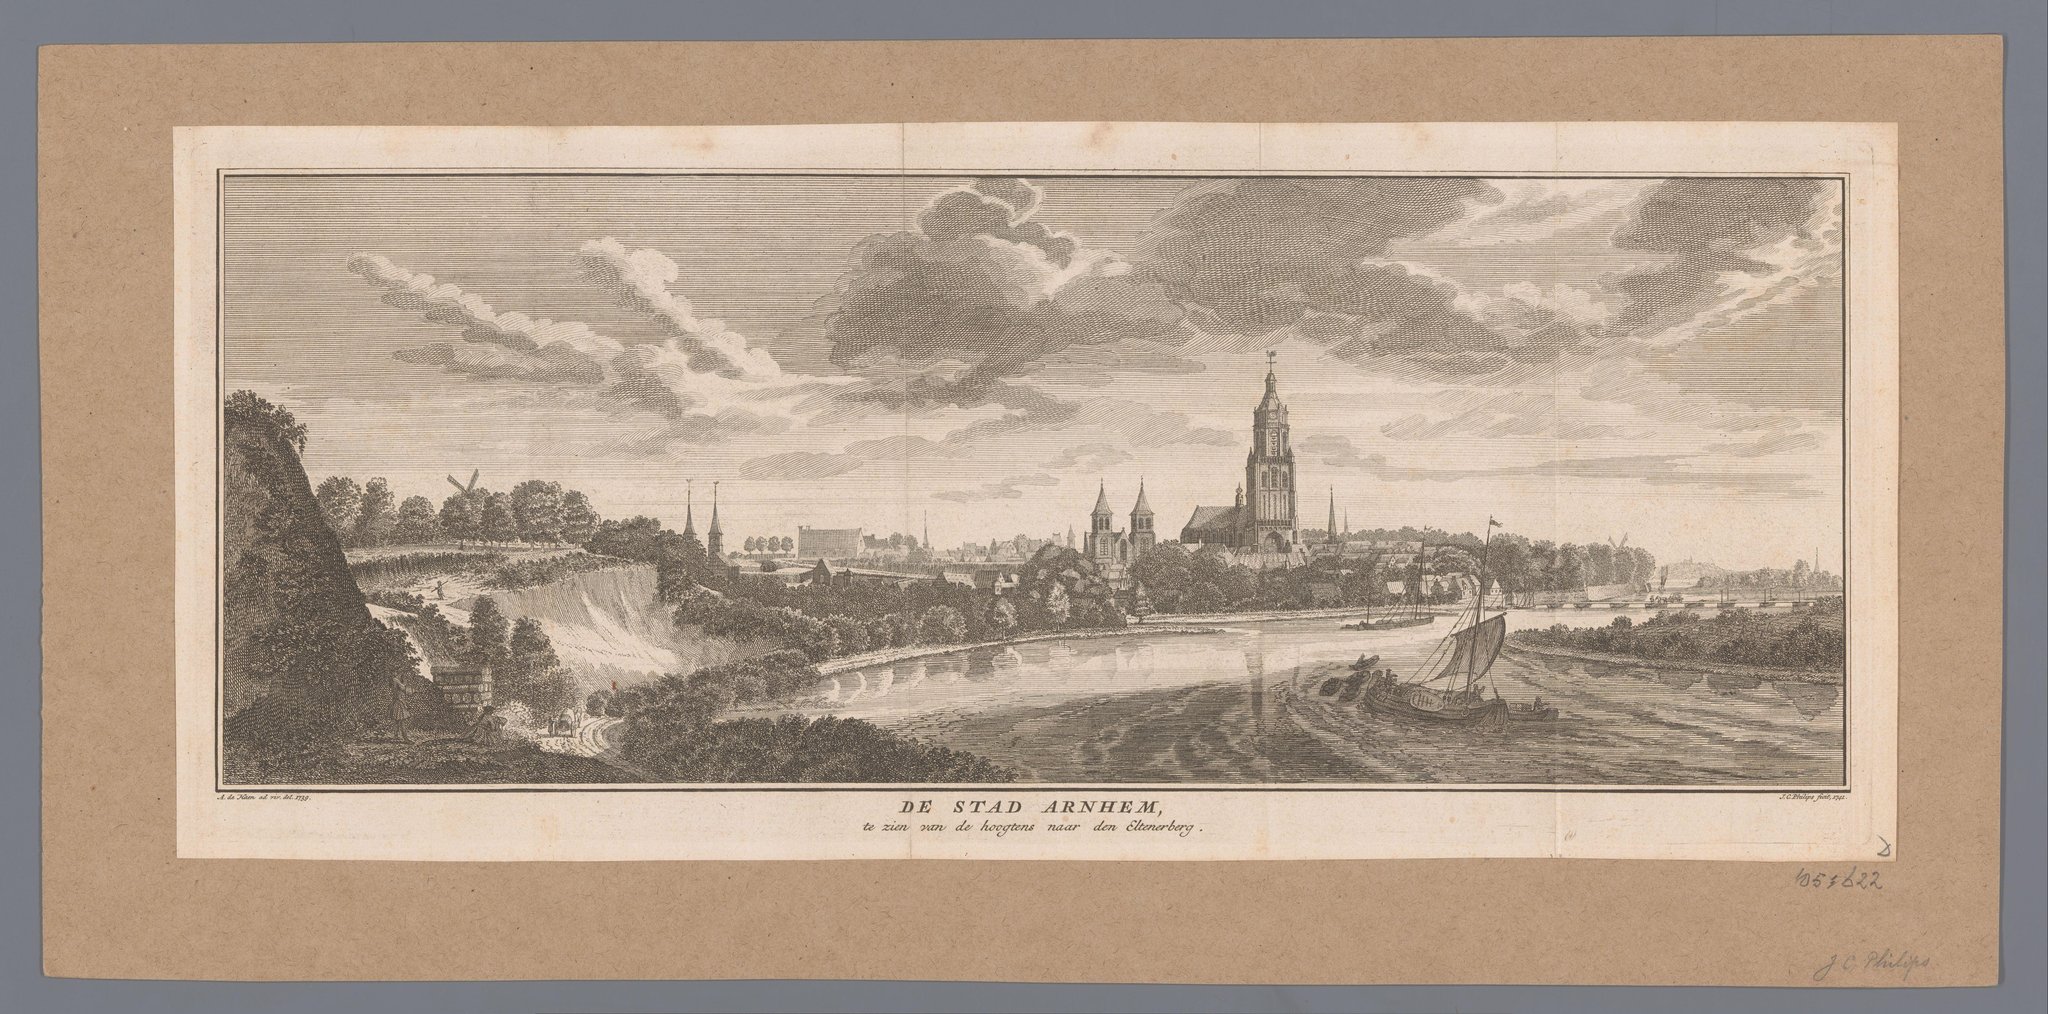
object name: book illustration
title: Gezicht op Arnhem, 1739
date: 1741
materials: paper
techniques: etching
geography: amsterdam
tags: river, prospect of city, town panorama, silhouette of city, arnhem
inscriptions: collector's mark: Lugt 2228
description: Prent uit: Wagenaar, Jan. Tegenwoordige staat der Vereenigde Nederlanden (…). Amsterdam: Isaak Tirion, 1741, dl. 3.